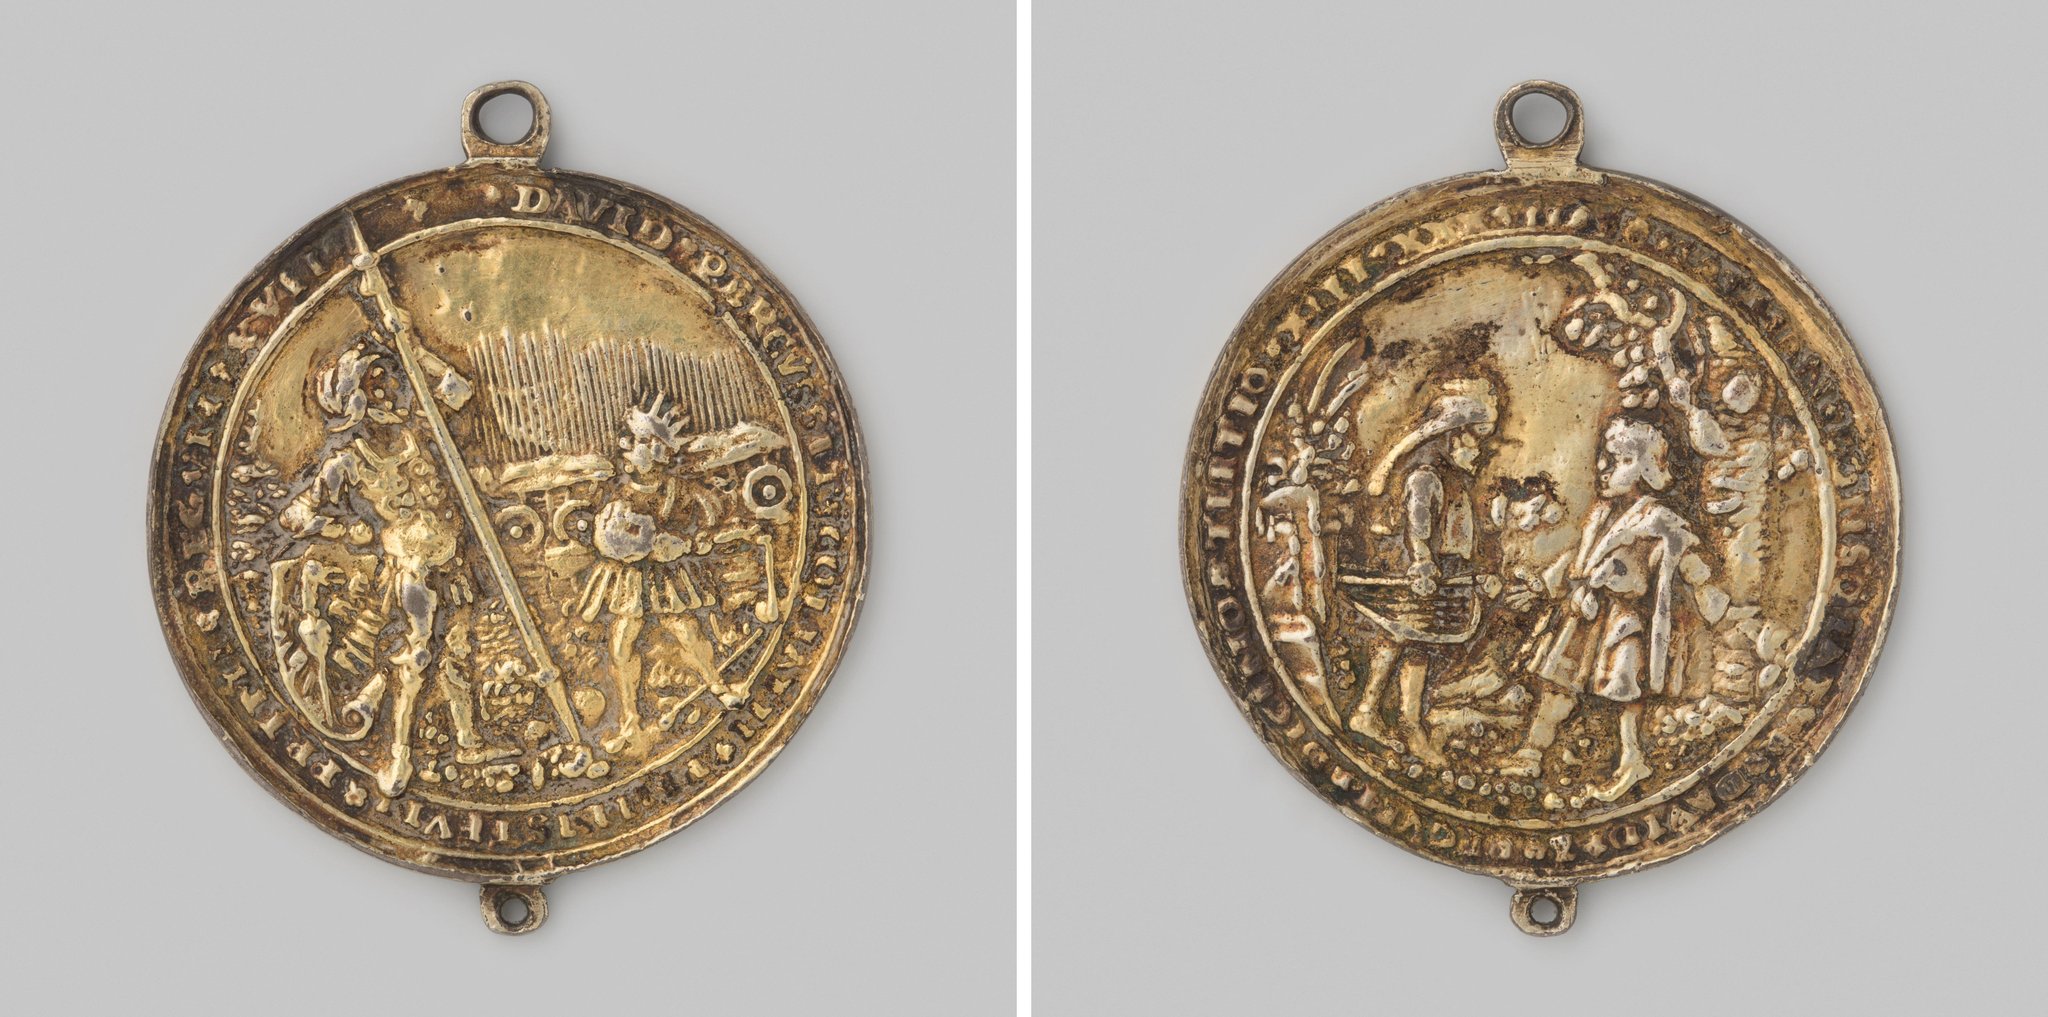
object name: draagpenning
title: Religieuze draagpenning met bijbelse voorstellingen (1628?)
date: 1628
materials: silver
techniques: casting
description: Vergulde penning met onder en boven een oogje, op de voorzijde David met slinger en Goliath met speer en schild met adelaar, met omschrift, op de keerzijde David met harp en zijn zoon ? onder een boom, met omschrift.